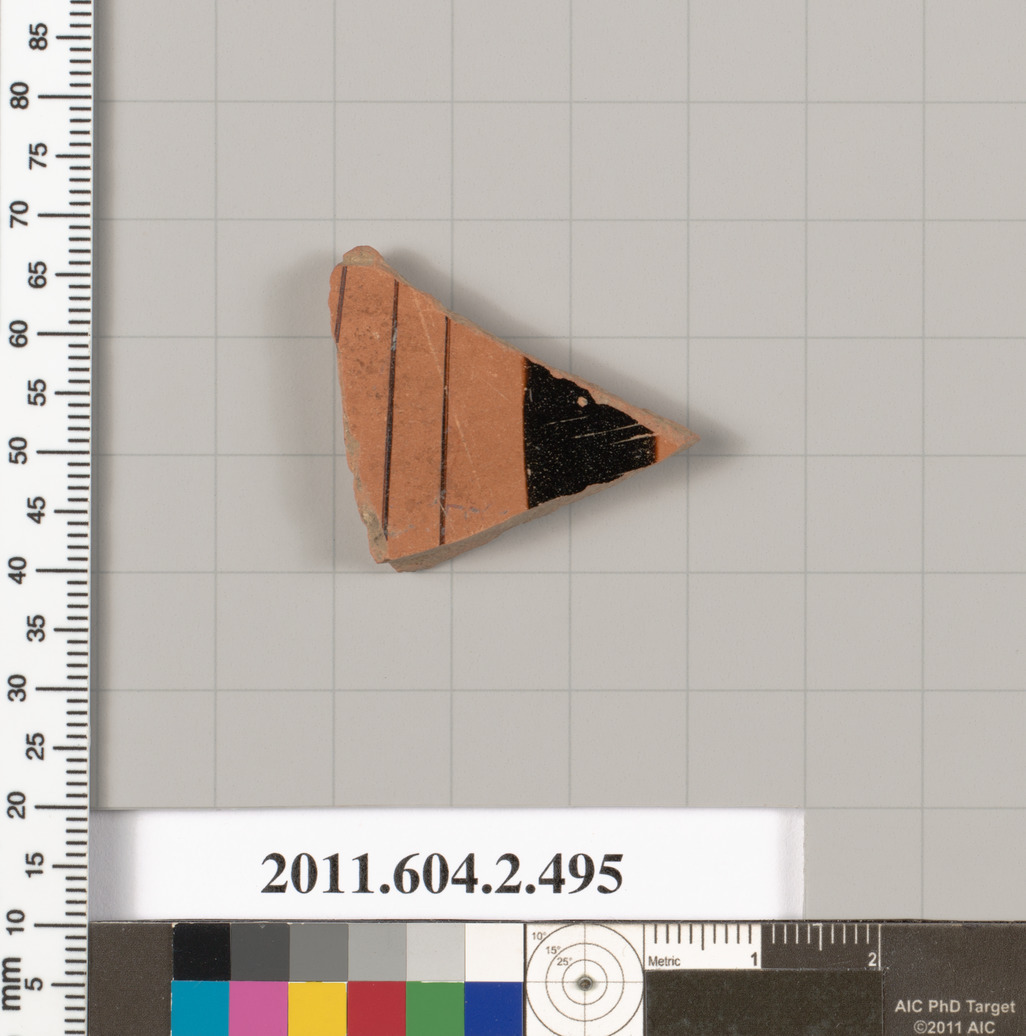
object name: column krater fragment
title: Terracotta fragment of a column-krater (bowl for mixing wine and water)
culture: greek, attic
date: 460-440 BCE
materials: terracotta